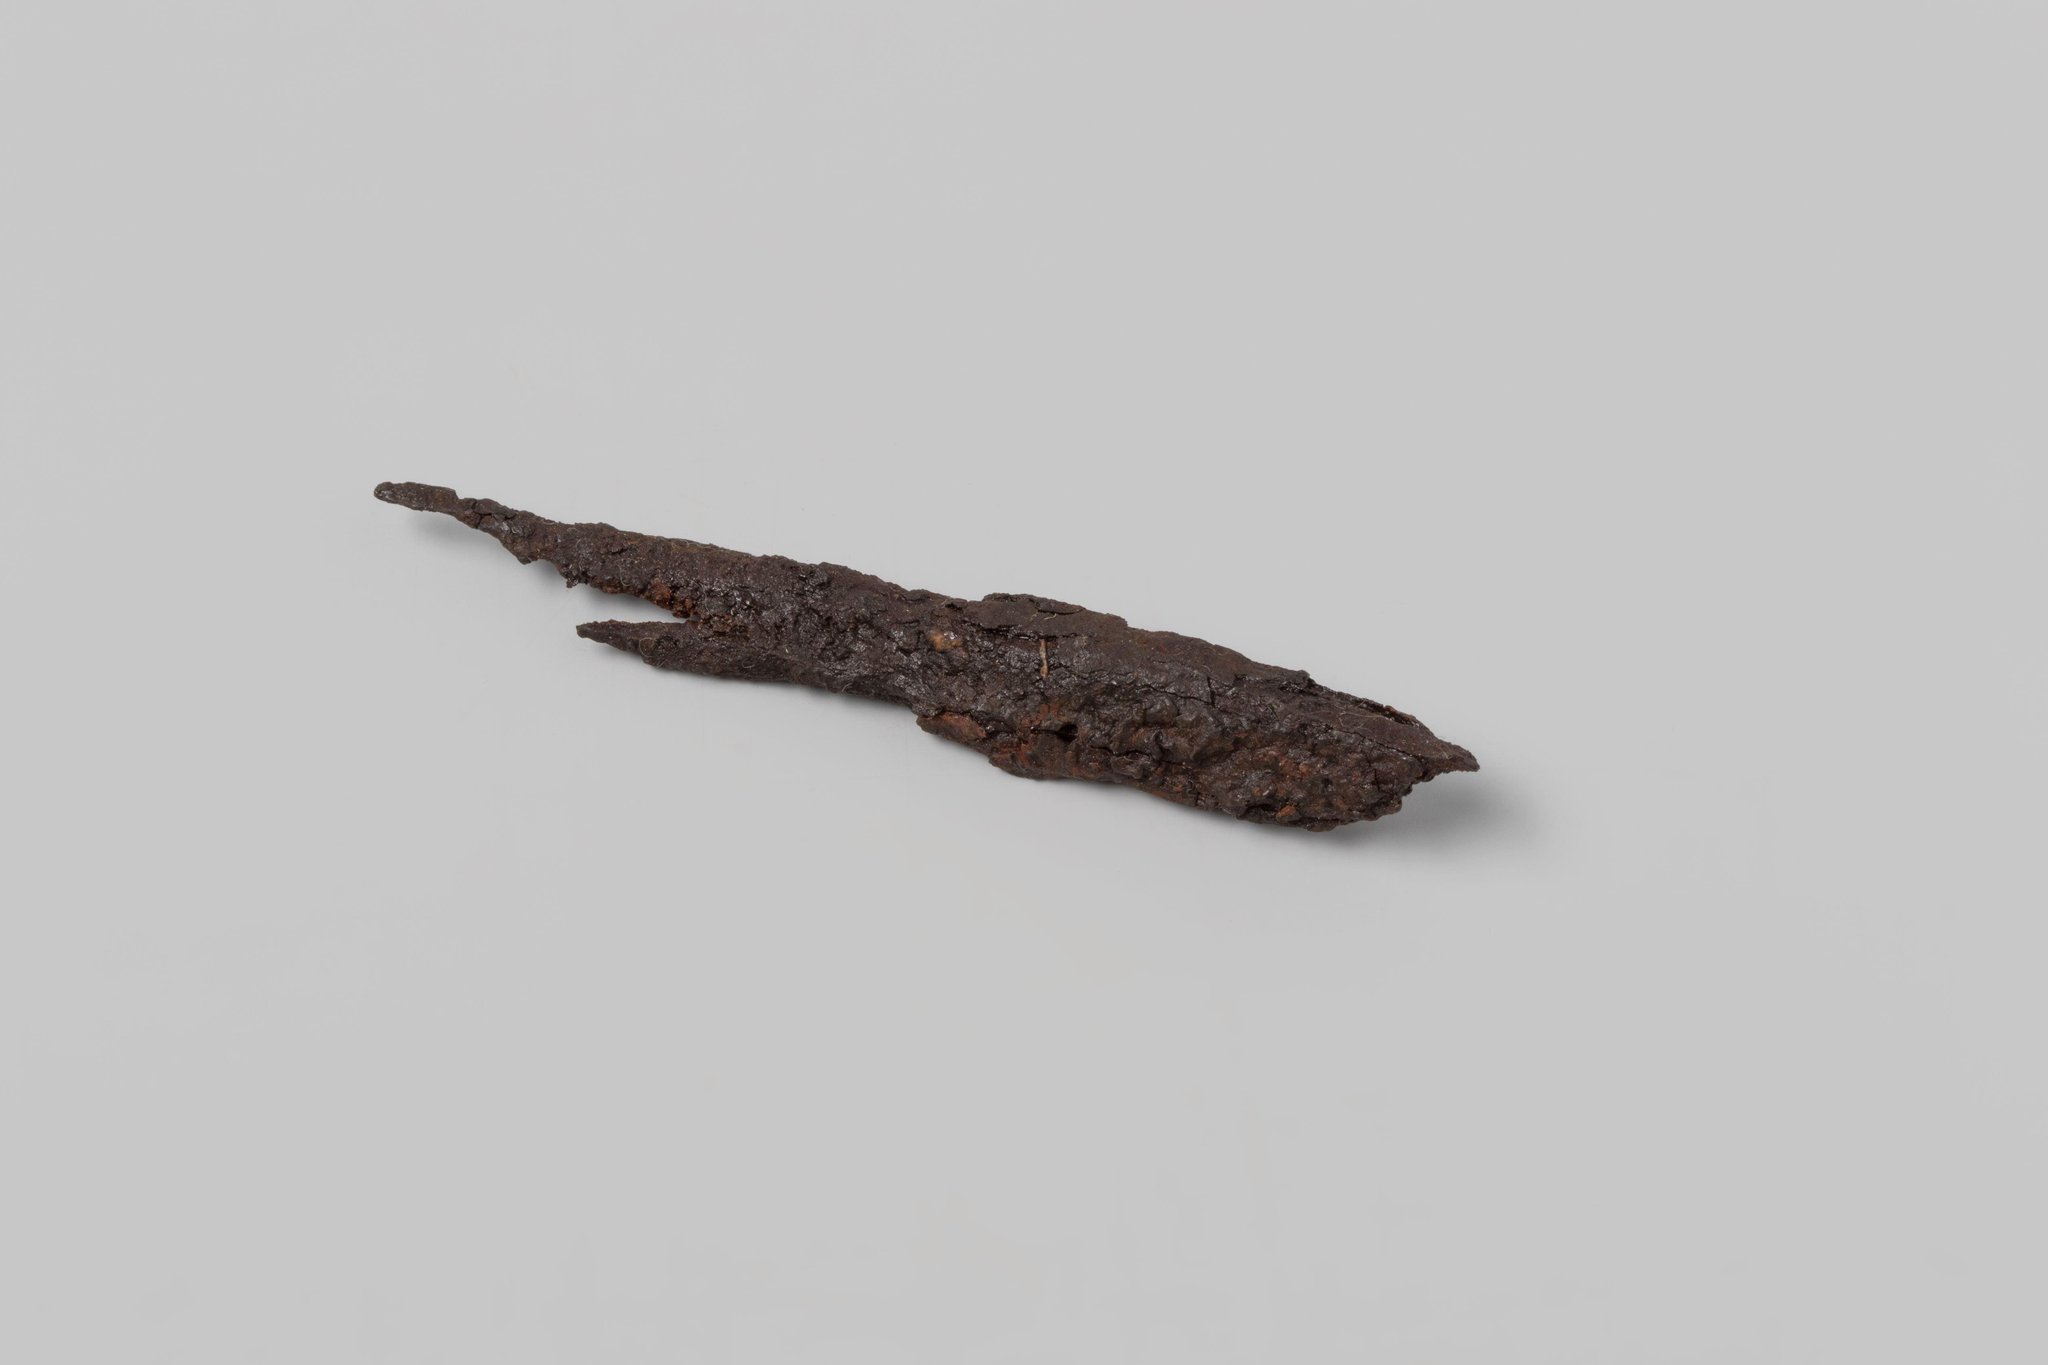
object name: fragment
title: Fragment ijzer uit het wrak van de Oost-Indiëvaarder Hollandia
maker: Anonymous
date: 1700-1743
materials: iron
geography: netherlands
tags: verenigde oostindische compagnie, hollandia (schip), annet